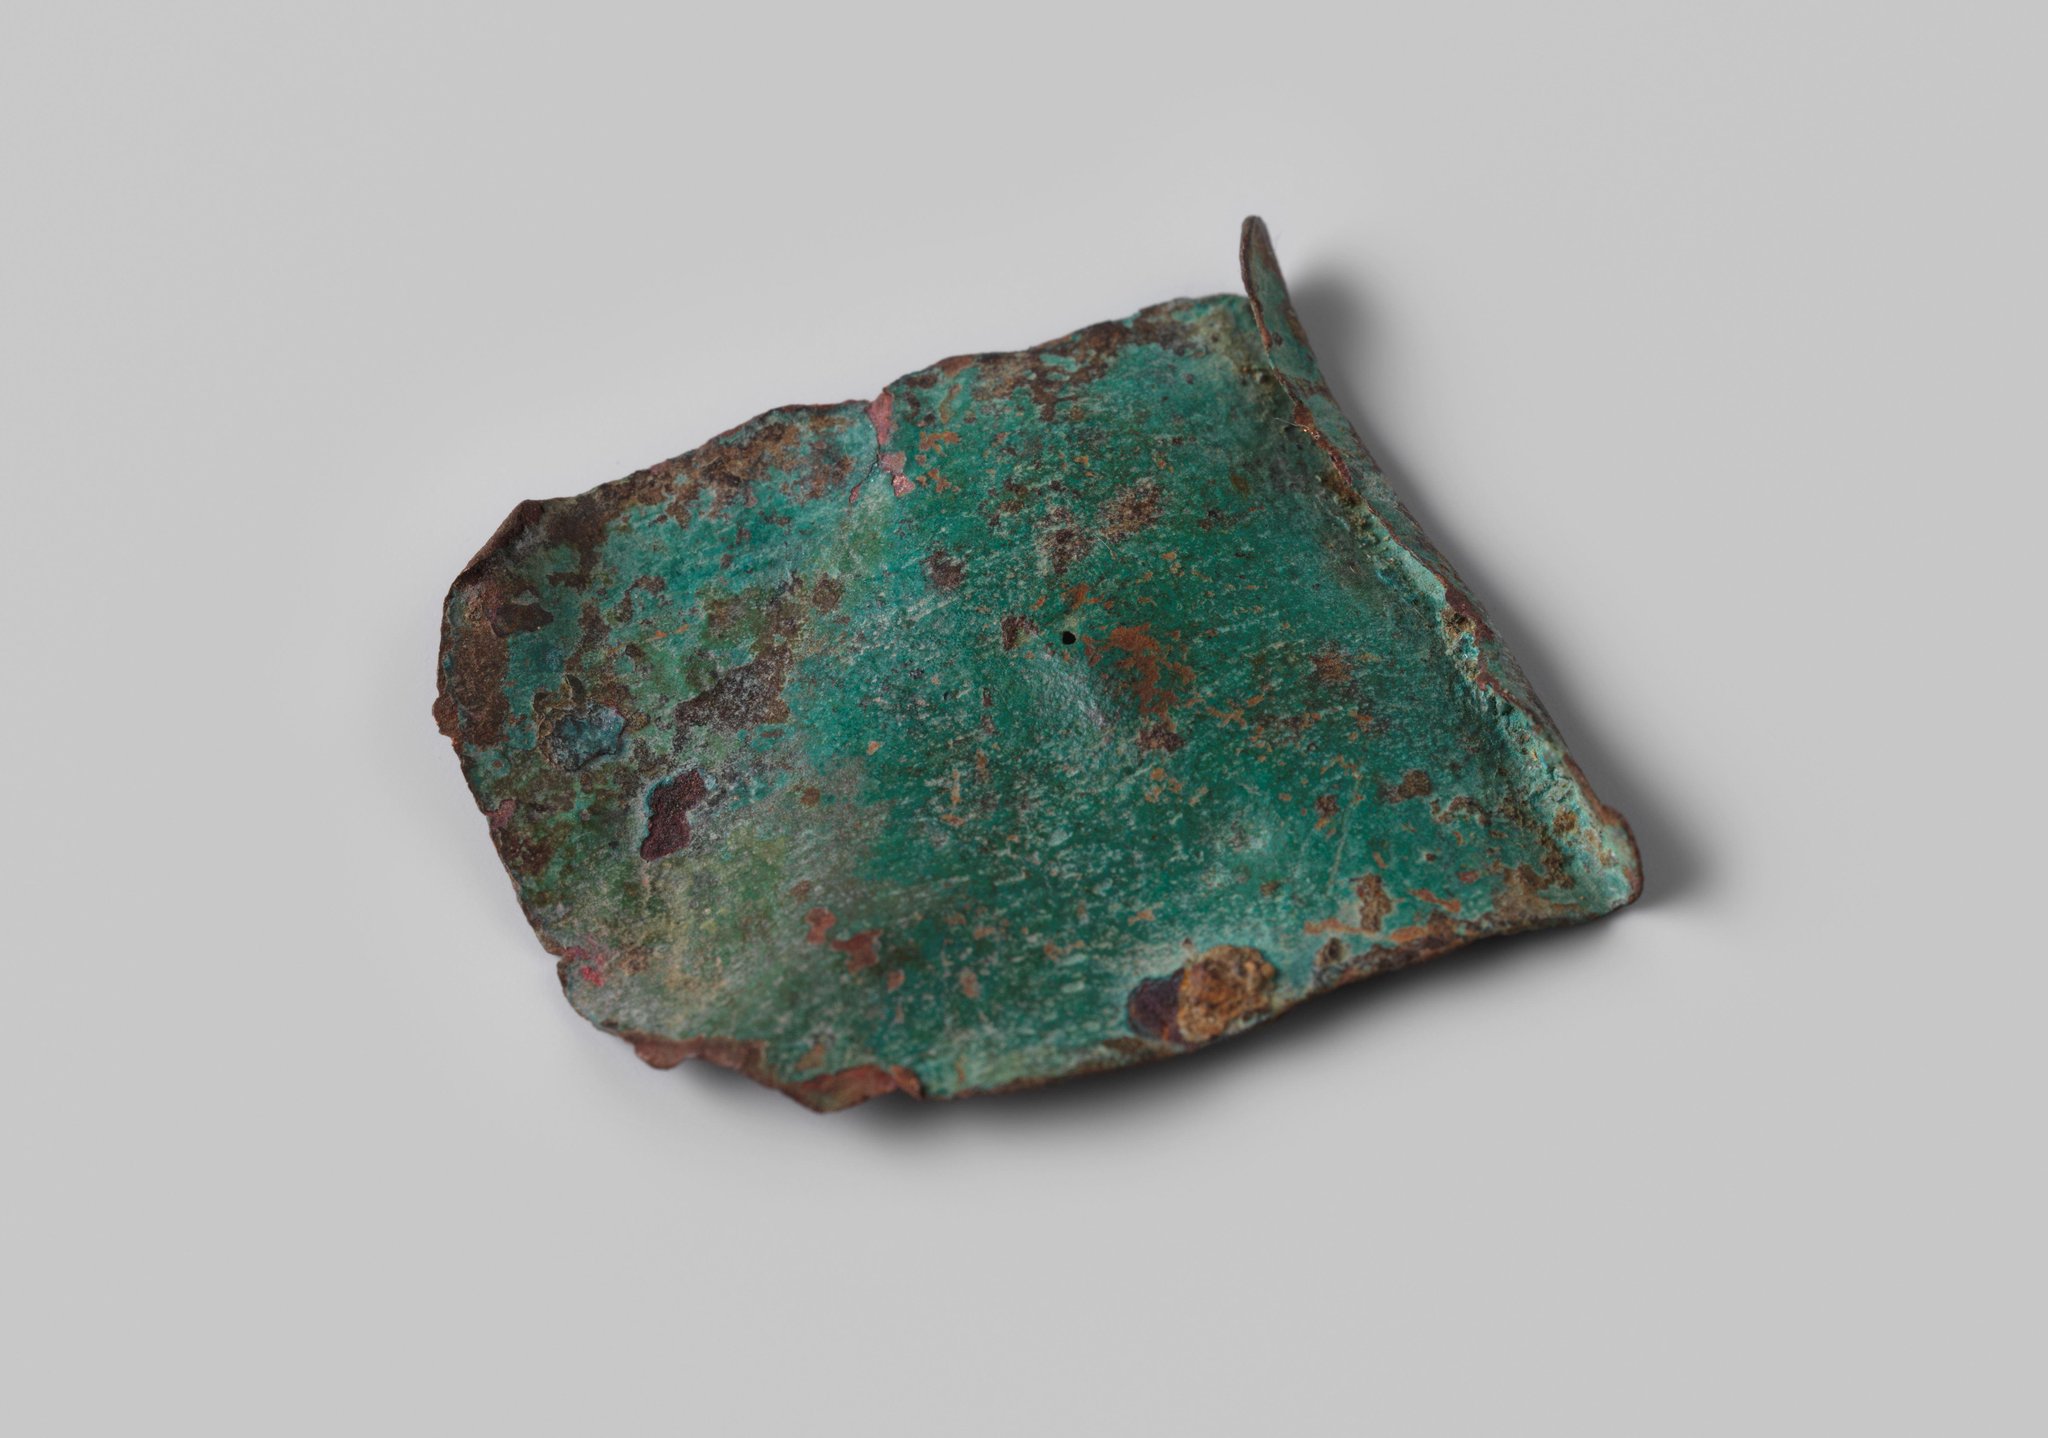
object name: fragment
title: Fragment van koper uit het wrak van de Oost-Indiëvaarder Hollandia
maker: Anonymous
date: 1700-1743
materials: copper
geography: netherlands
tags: verenigde oostindische compagnie, hollandia (schip), annet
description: Varied parts or fragments, strips and strip-shaped fragments; fragm.